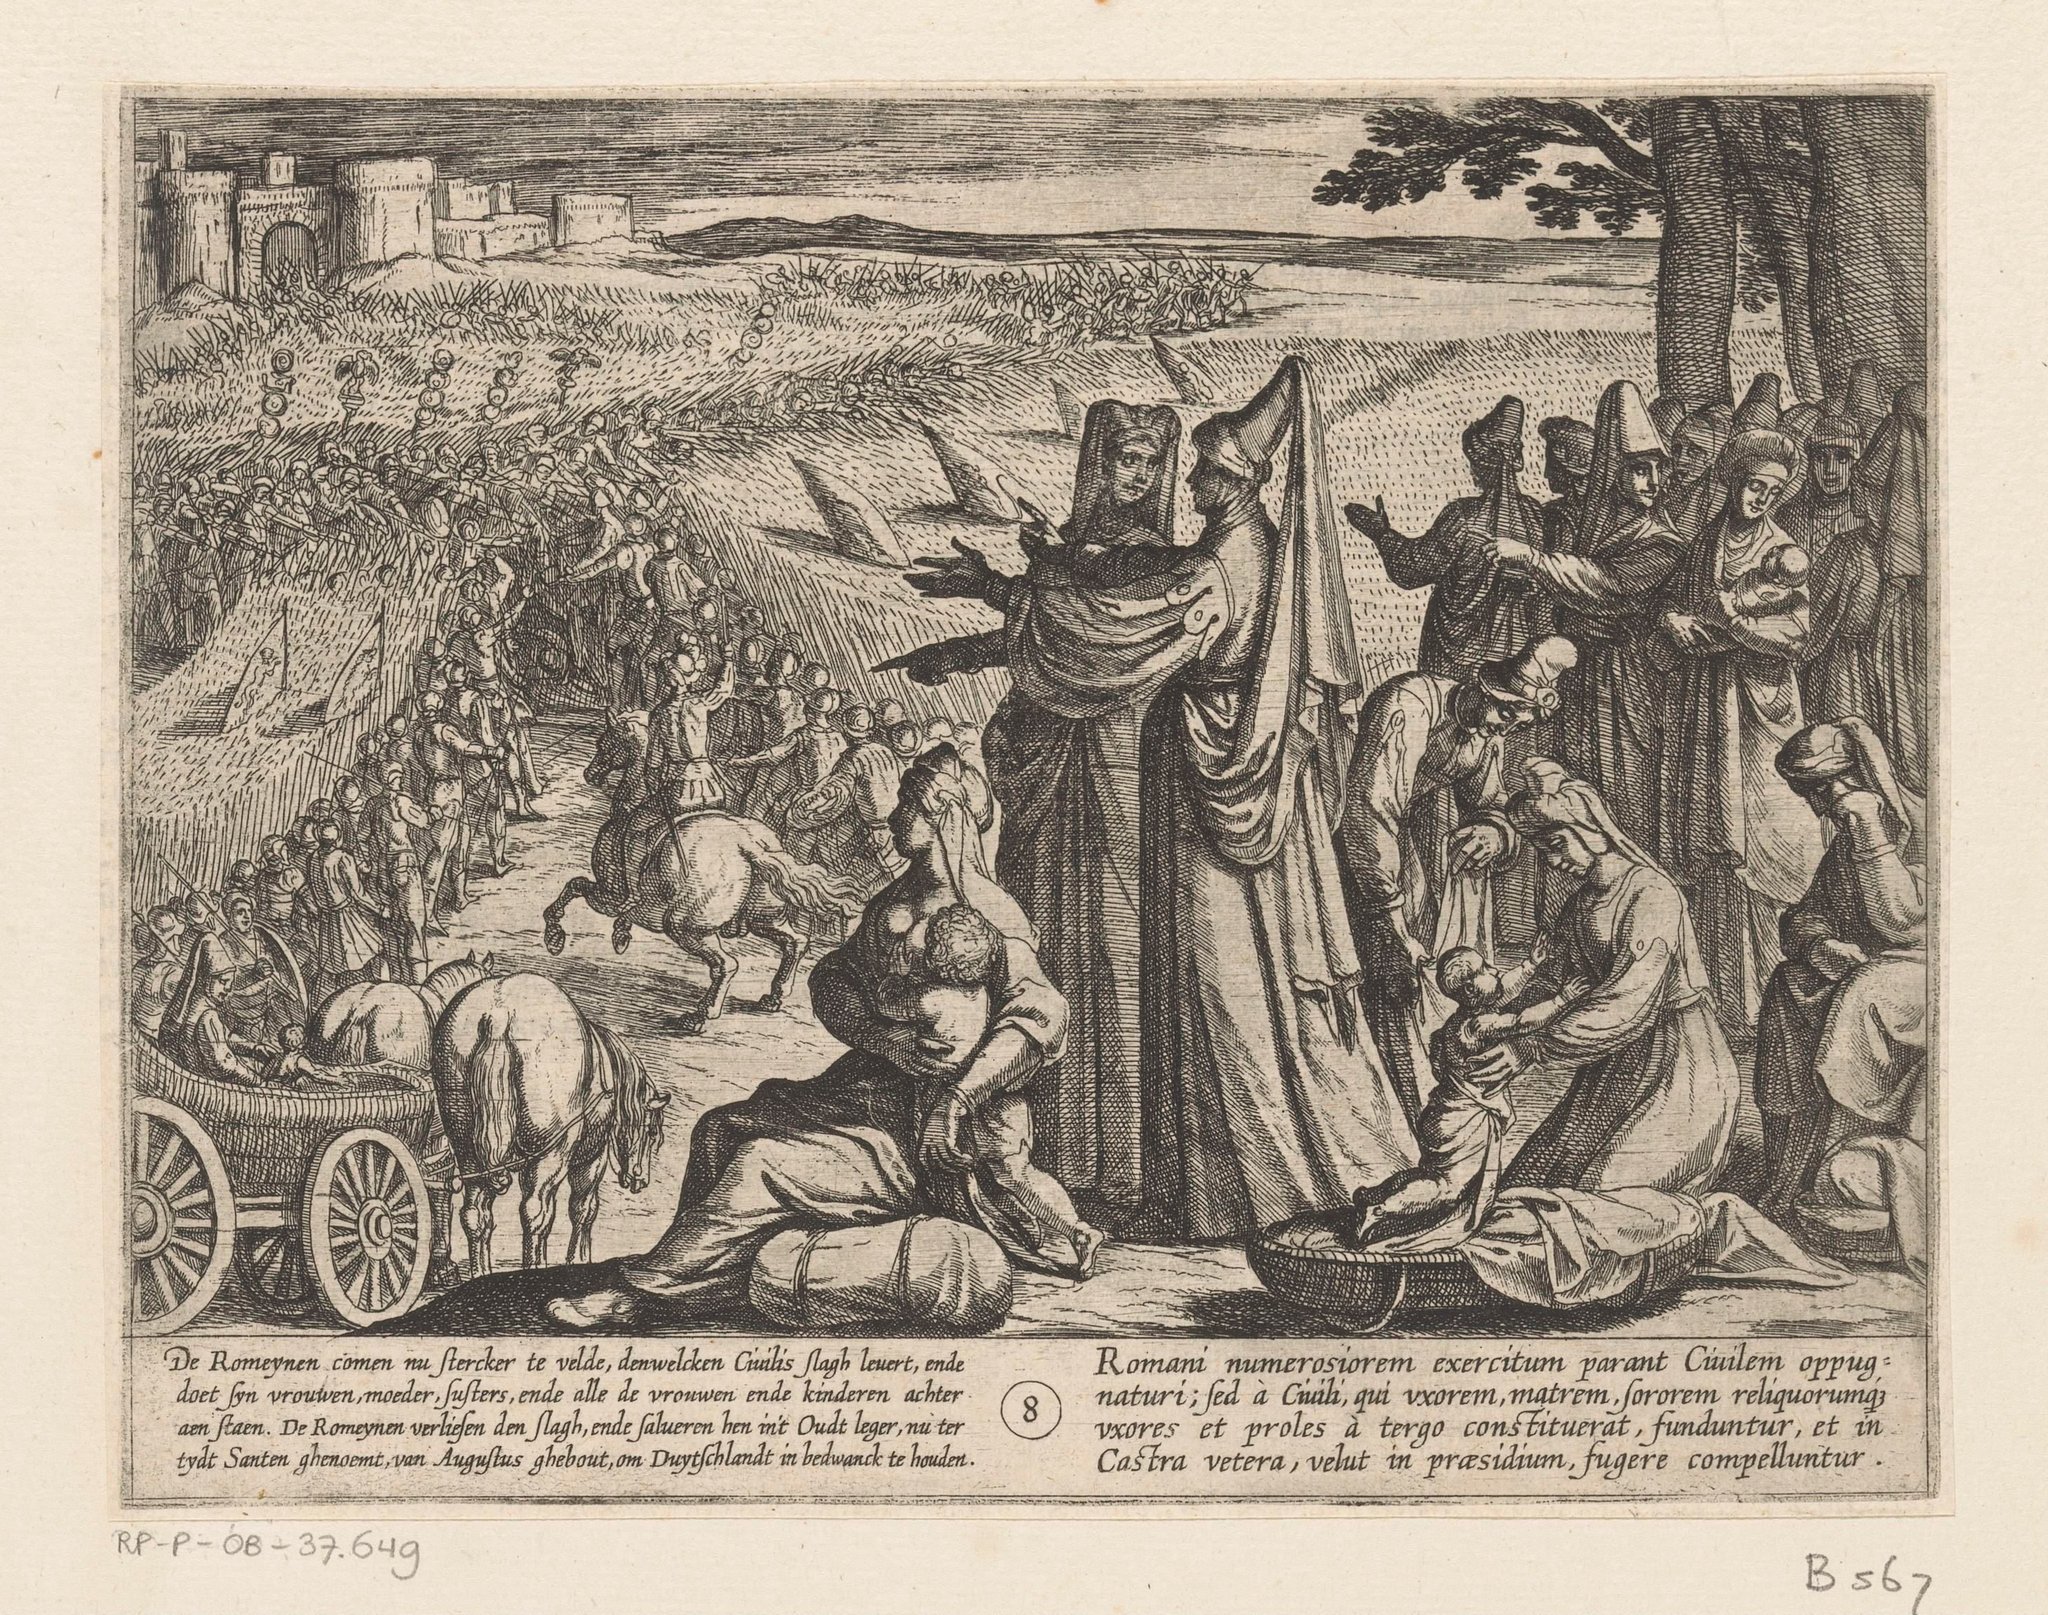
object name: print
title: Vrouwen en kinderen kijken hoe Julius Civilis de Romeinen verslaat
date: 1611-1612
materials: paper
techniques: etching, letterpress printing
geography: italy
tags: battle, the soldier; the soldier's life, (story of) julius claudius civilis, extinct, 'historical' peoples (with name)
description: Vrouwen en kinderen kijken van een afstandje toe hoe Julius Civilis en zijn Bataafse soldaten de Romeinen verslaan. Onderschrift in het Nederlands en in het Latijn.